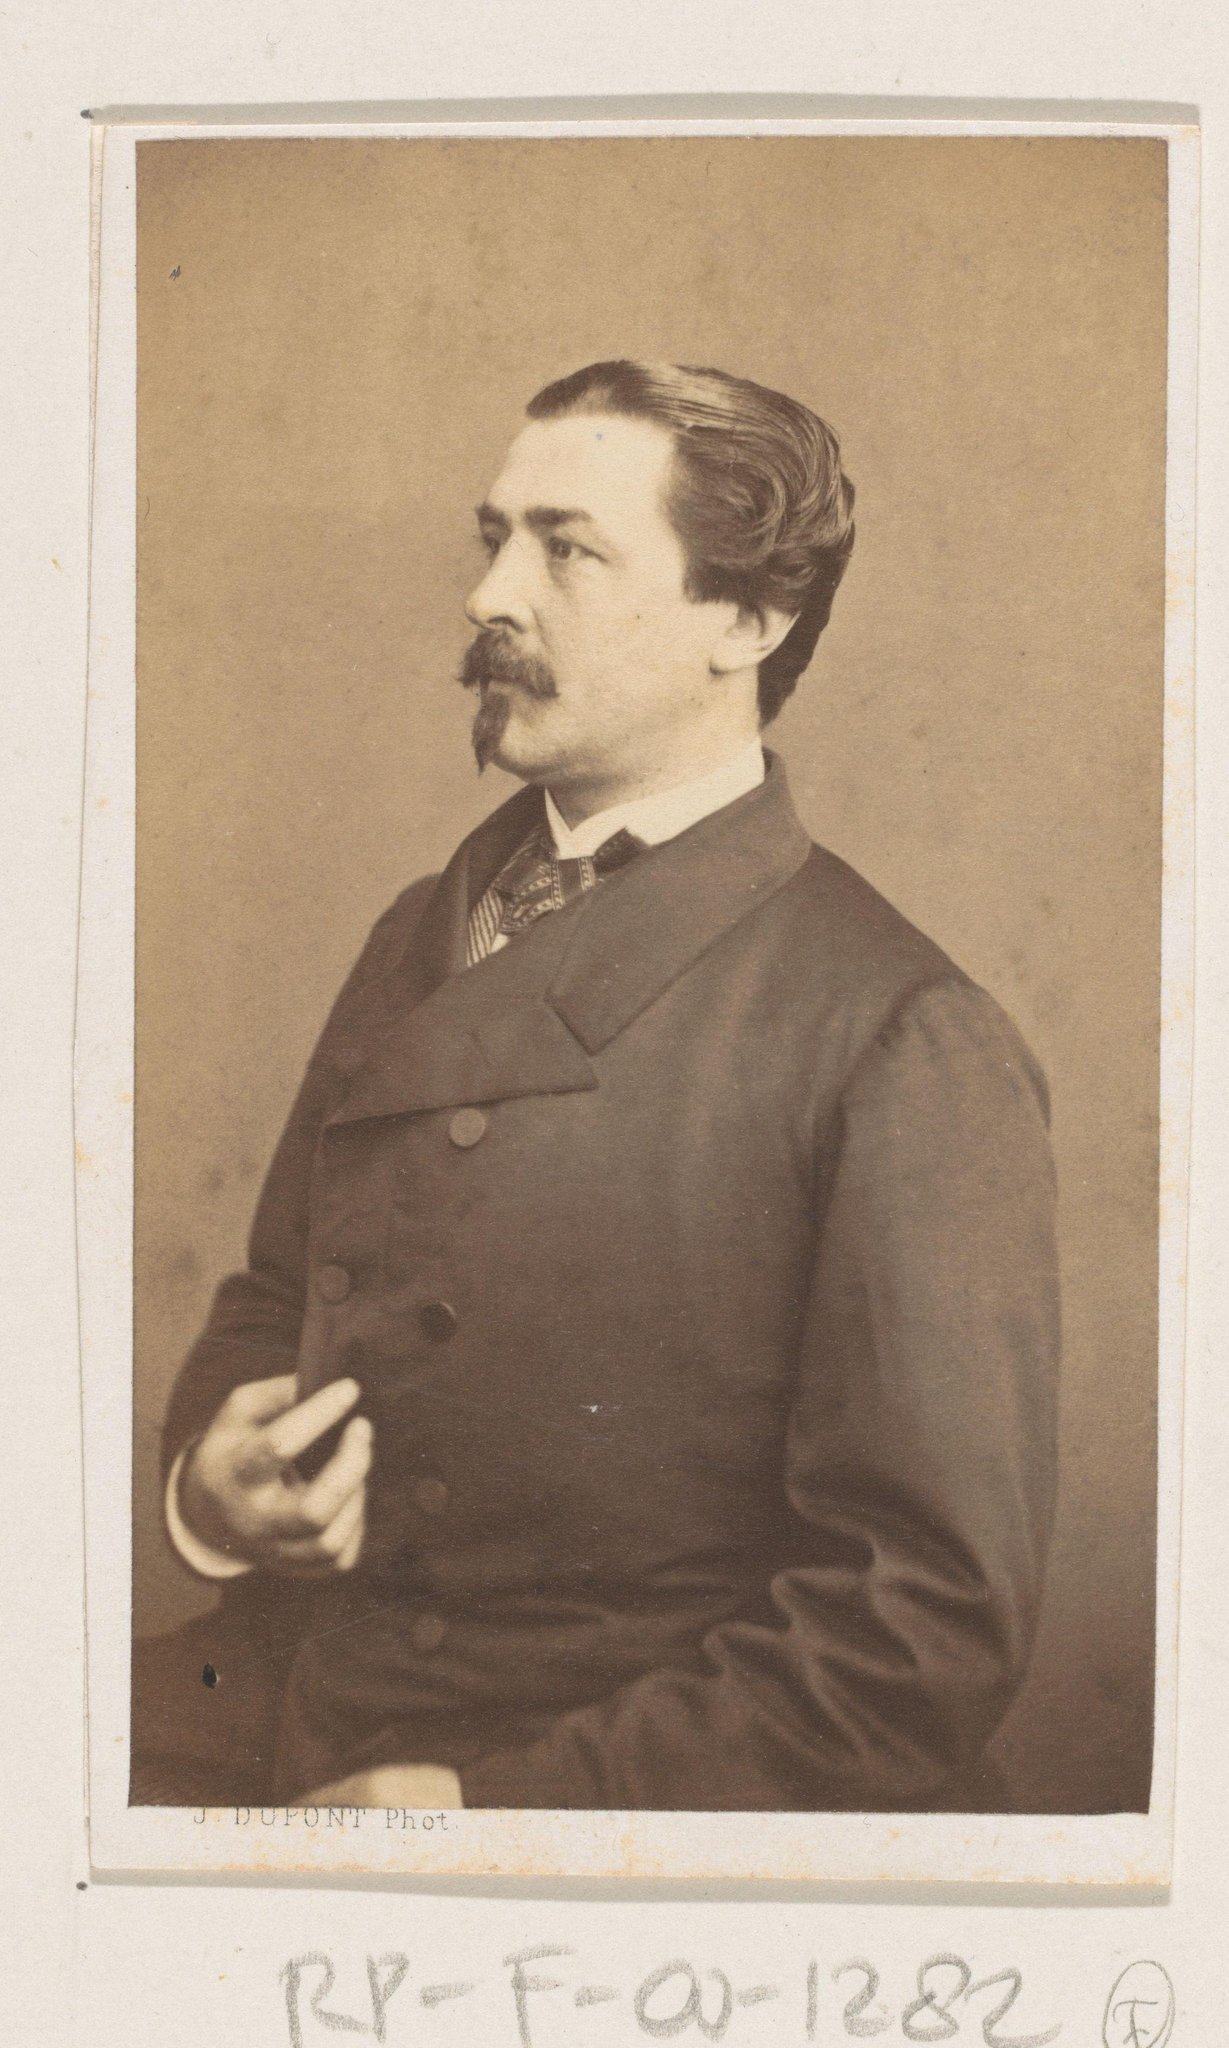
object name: photograph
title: L'École d'Anvers. Portraits biographies cartes de visite. Collection Dupont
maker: joseph dupont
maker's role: fotograaf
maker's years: 1818-1901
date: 1861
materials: cardboard, paper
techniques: albumen print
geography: antwerp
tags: joseph delin, historical persons, portrait, self-portrait of painter, portrait, self-portrait of artist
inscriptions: inscription: ‘ETABLISSEMENT PHOTOGRAPHIQUE/ de/ J. DUPONT/ Place de Meir 32/ ANVERS/ Maison fondée en 1853’, inscription: ‘Delin Joseph/ peintre de portraits/ né a Anvers/ le 6. VII 1822/ élève de l'academie/ Royal et au baron/ G Wappers’